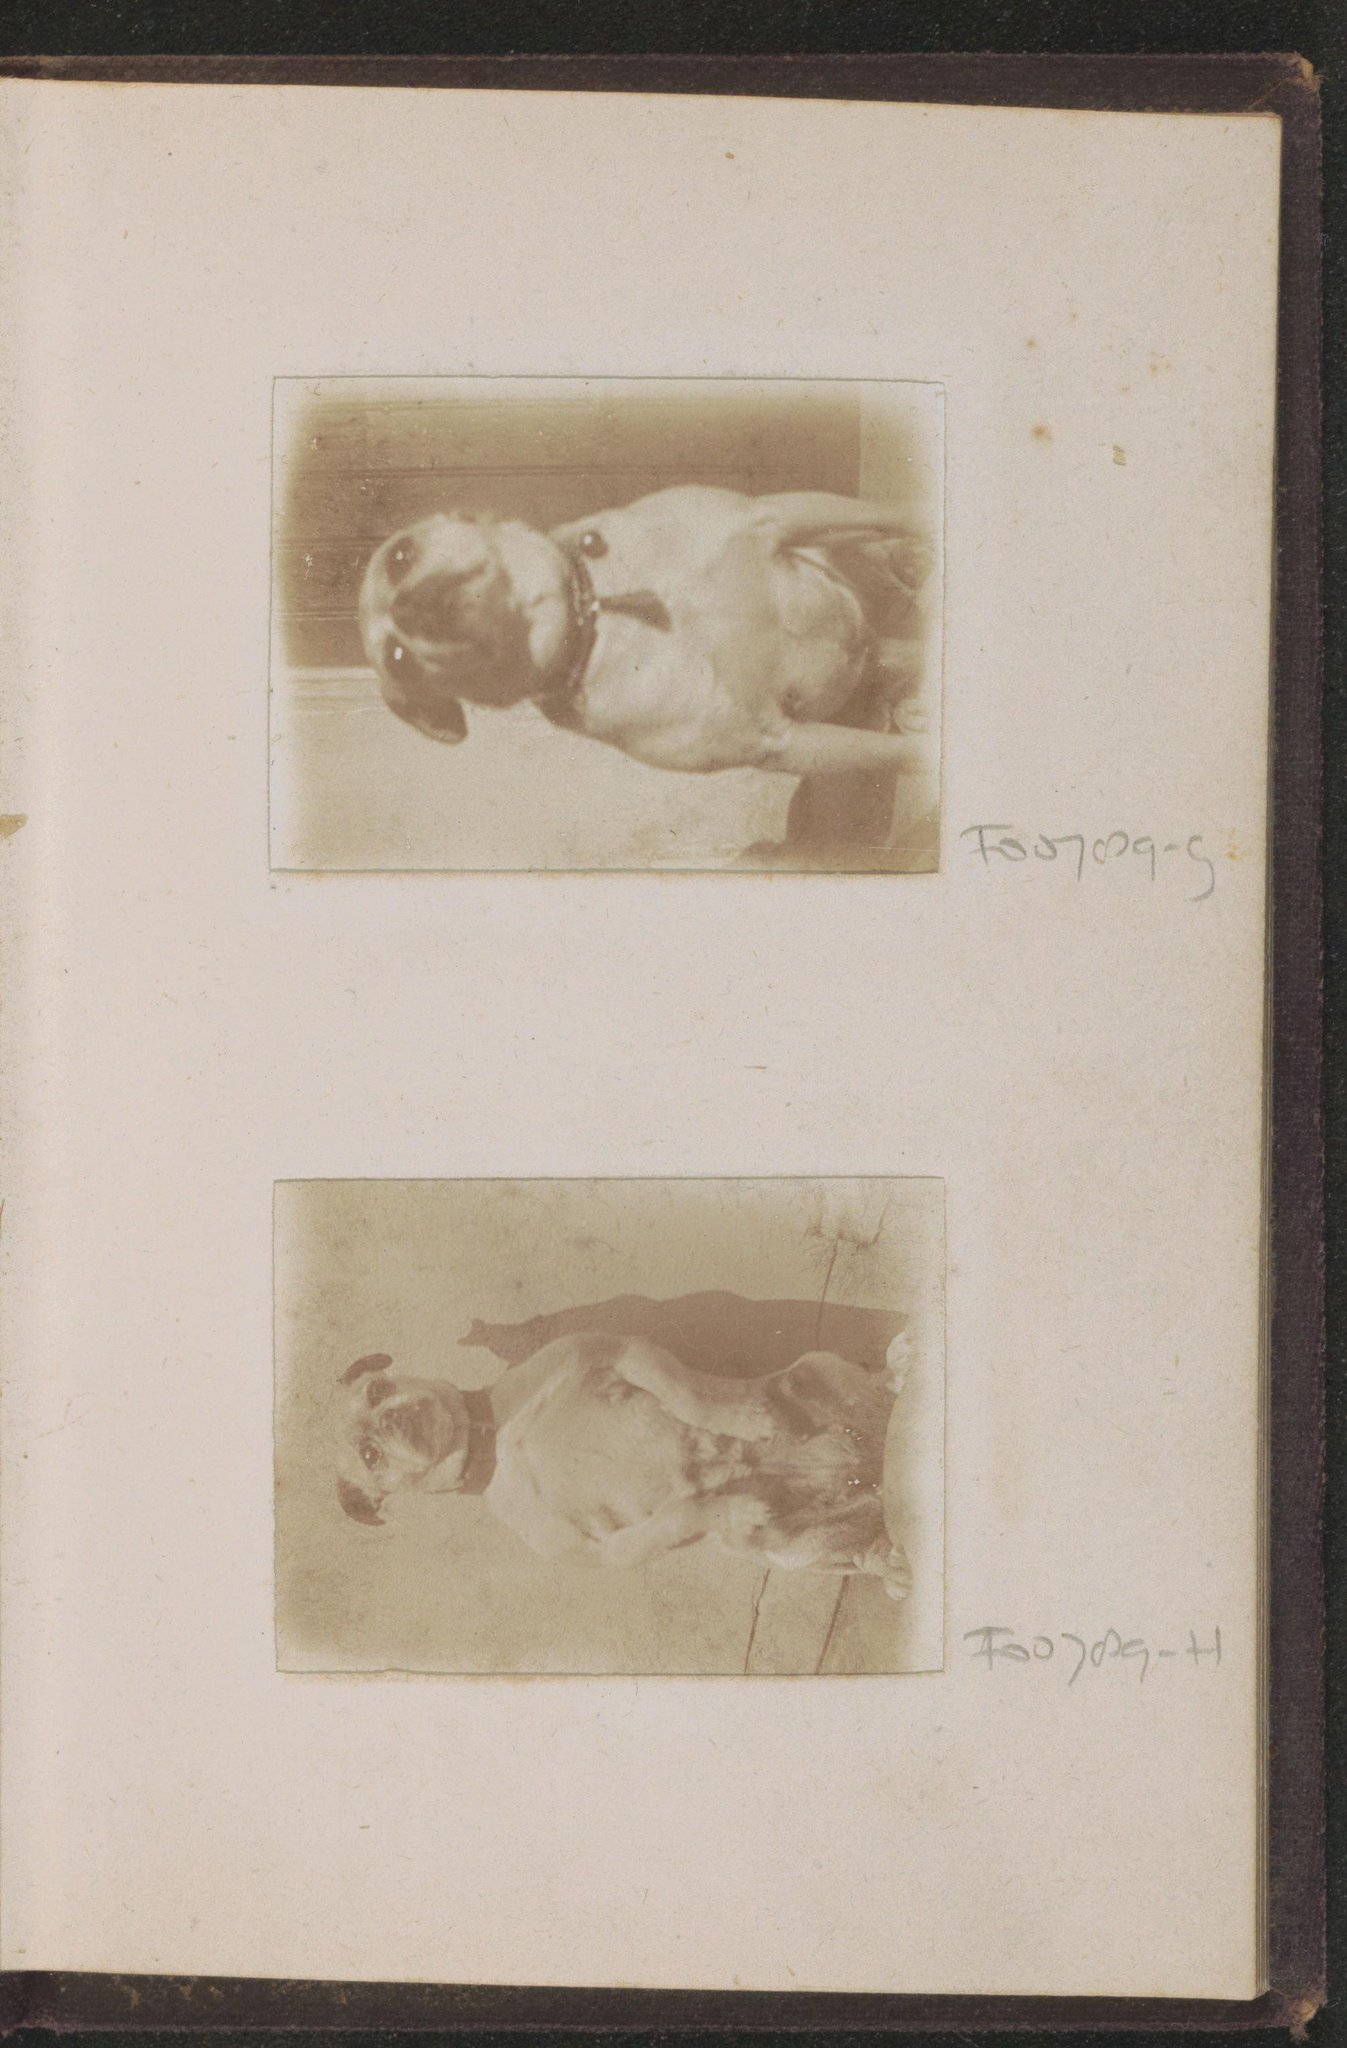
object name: photograph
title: Portret van een mopshond, staand op twee poten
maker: Anonymous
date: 1880-1900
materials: paper, photographic support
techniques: collodion silver print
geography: netherlands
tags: dog, netherlands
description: Onderdeel van Fotoalbum met 35 foto's van Amsterdam, personen en dieren.